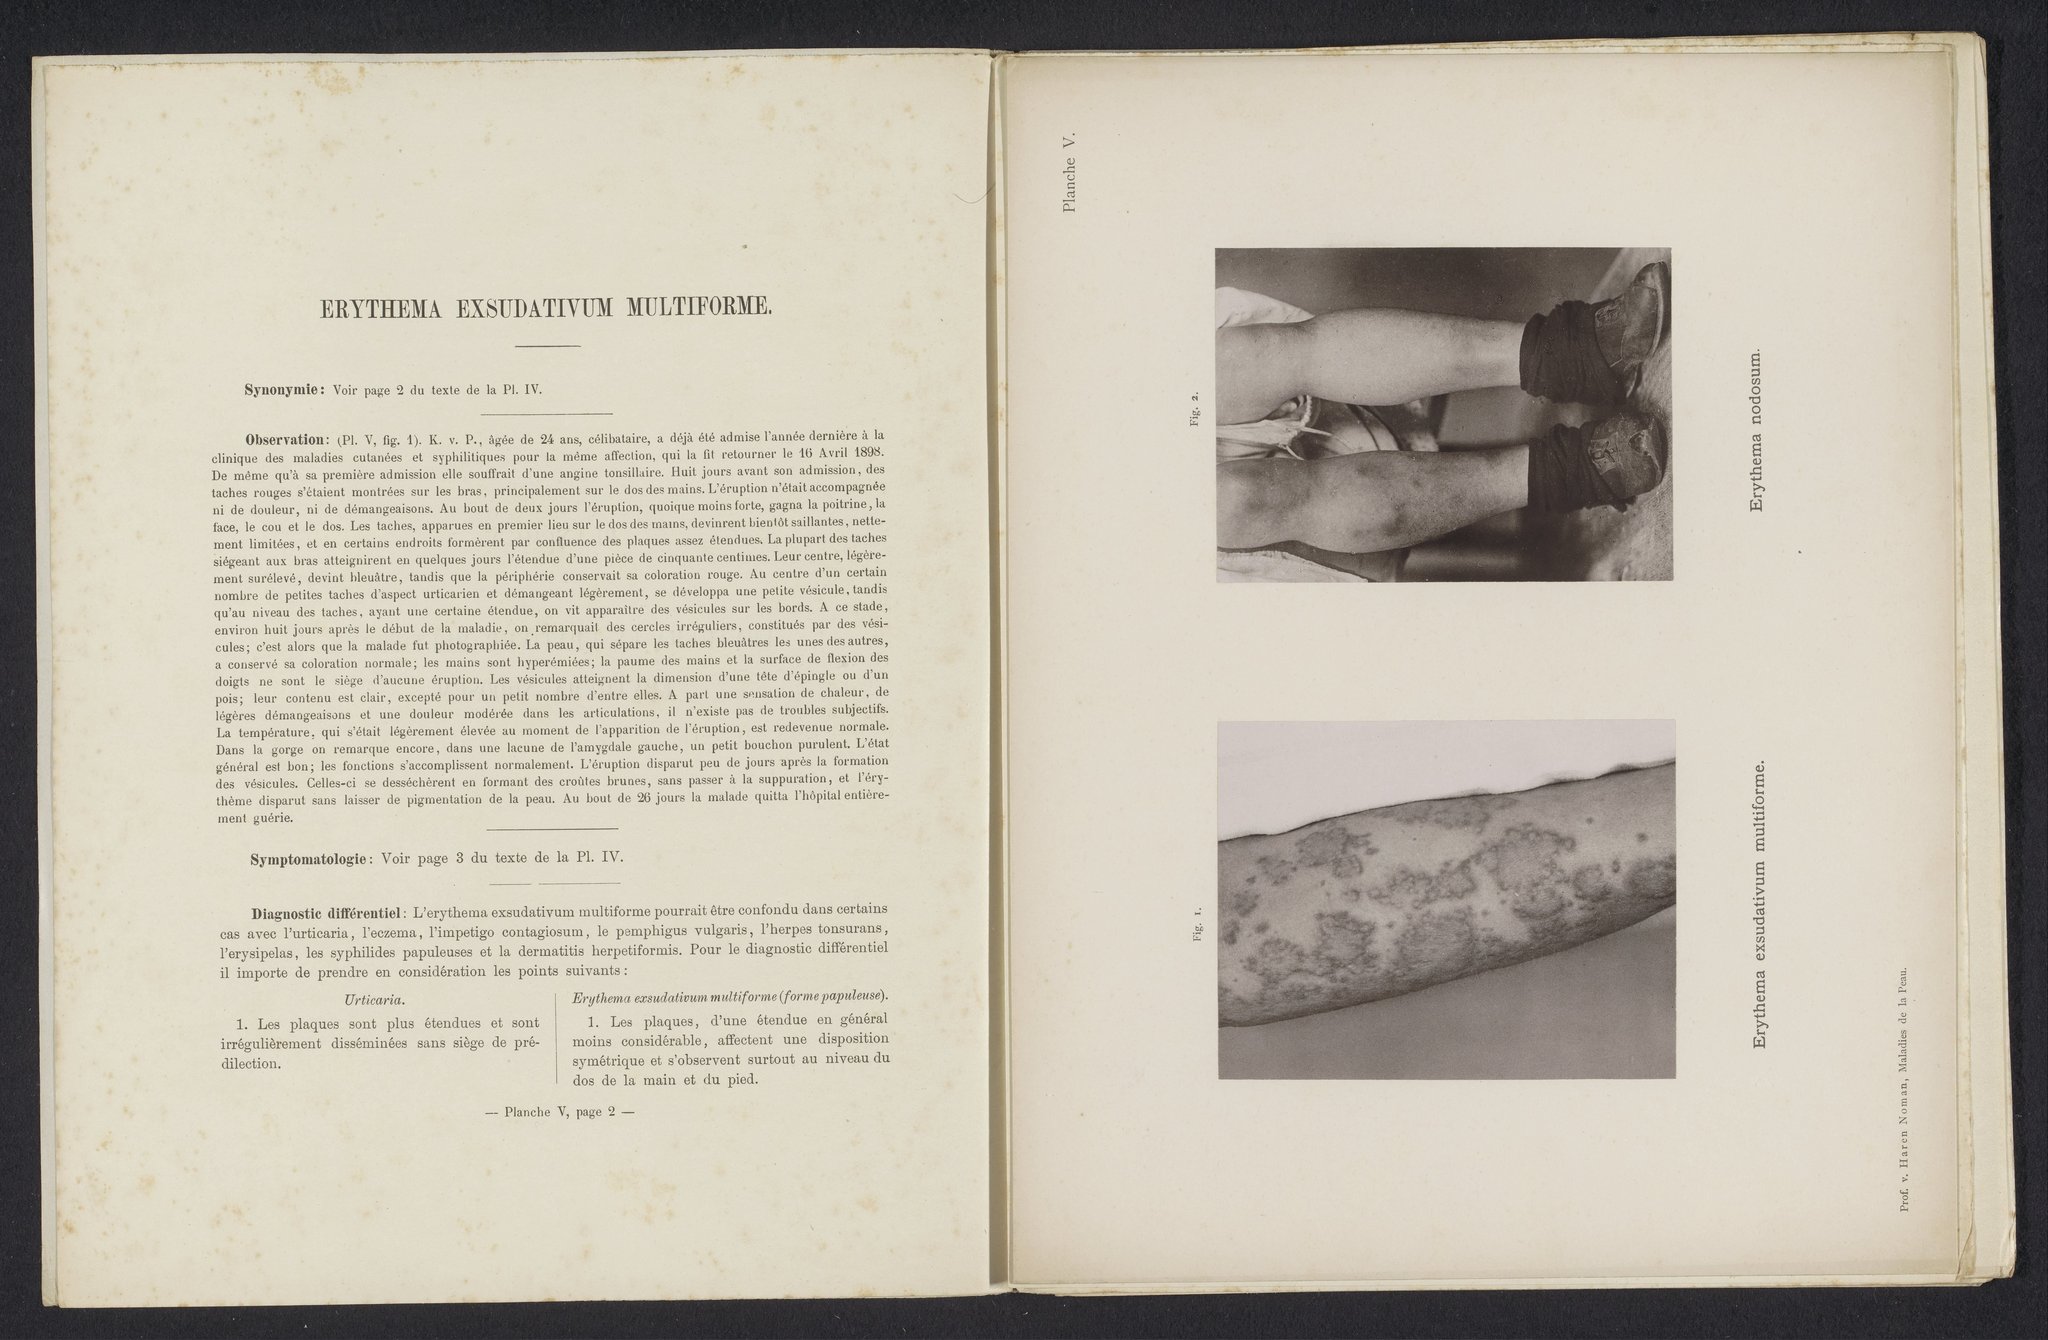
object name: photomechanical print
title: Erythema exsudativum multiforme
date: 1888-1898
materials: paper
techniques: photograph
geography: amsterdam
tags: skin and venereal diseases, legs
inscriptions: number: ‘Planche V. / Fig. 1. / Fig. 2.’